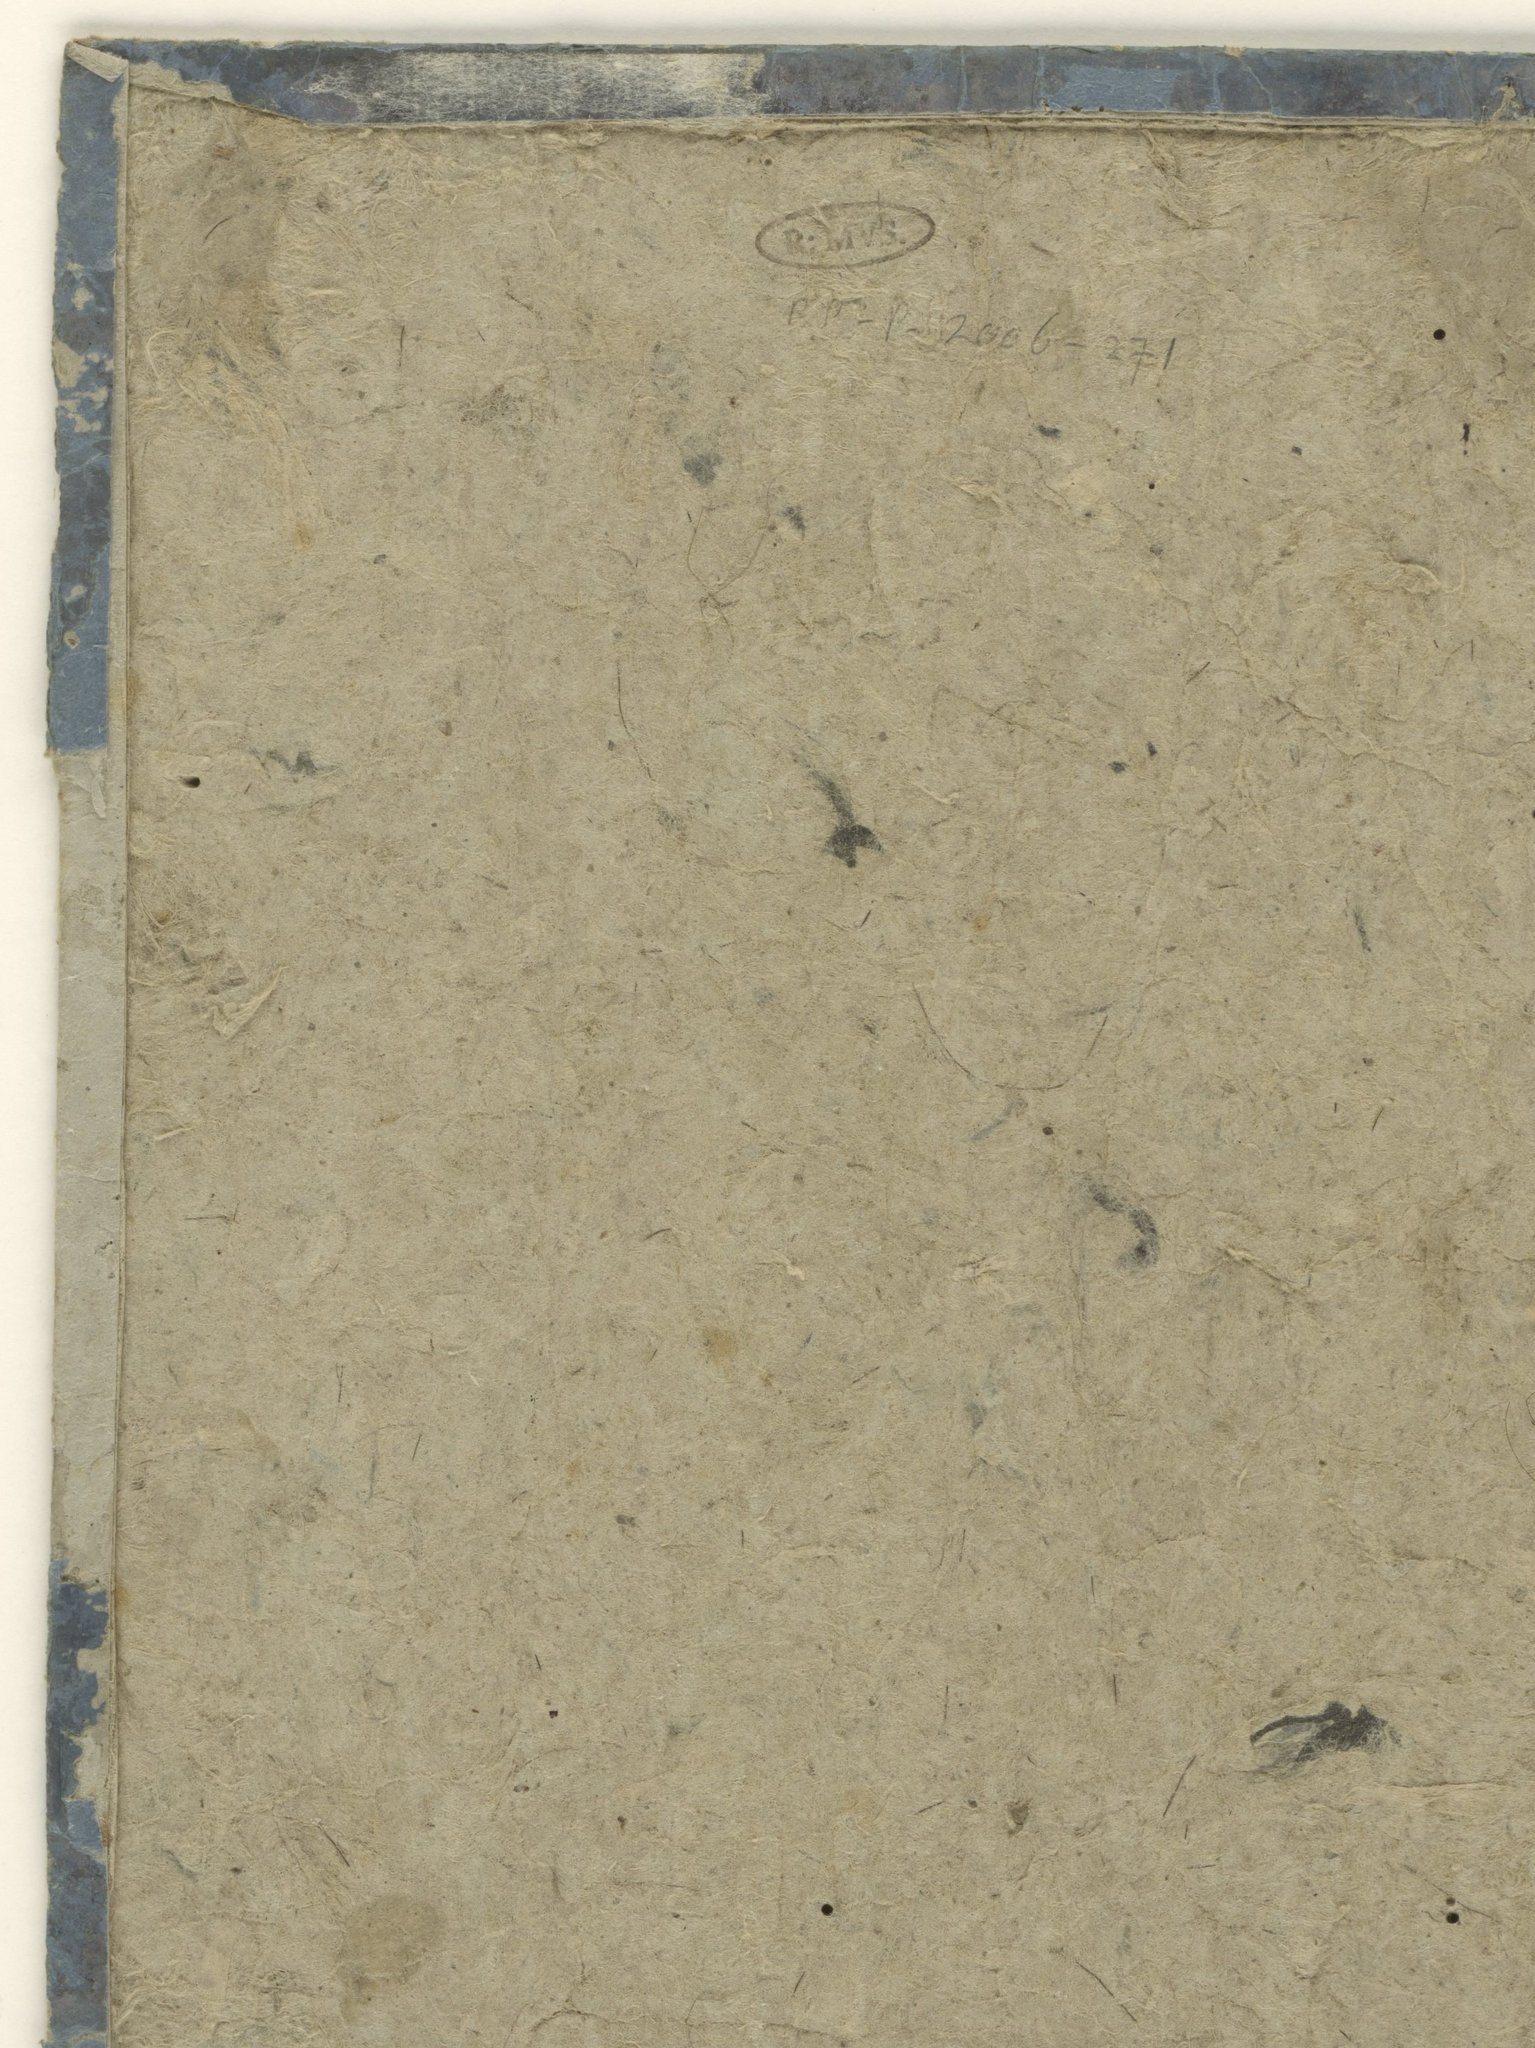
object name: wrapper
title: Negai no itoguchi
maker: kitagawa utamaro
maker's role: print maker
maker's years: 1753-1806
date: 1799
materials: paper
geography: japan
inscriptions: collector's mark: Lugt 2228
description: Achterkant van het album Negai no itoguchi (ook wel vertaald met: The prelude to desire). Blauw papier over karton.